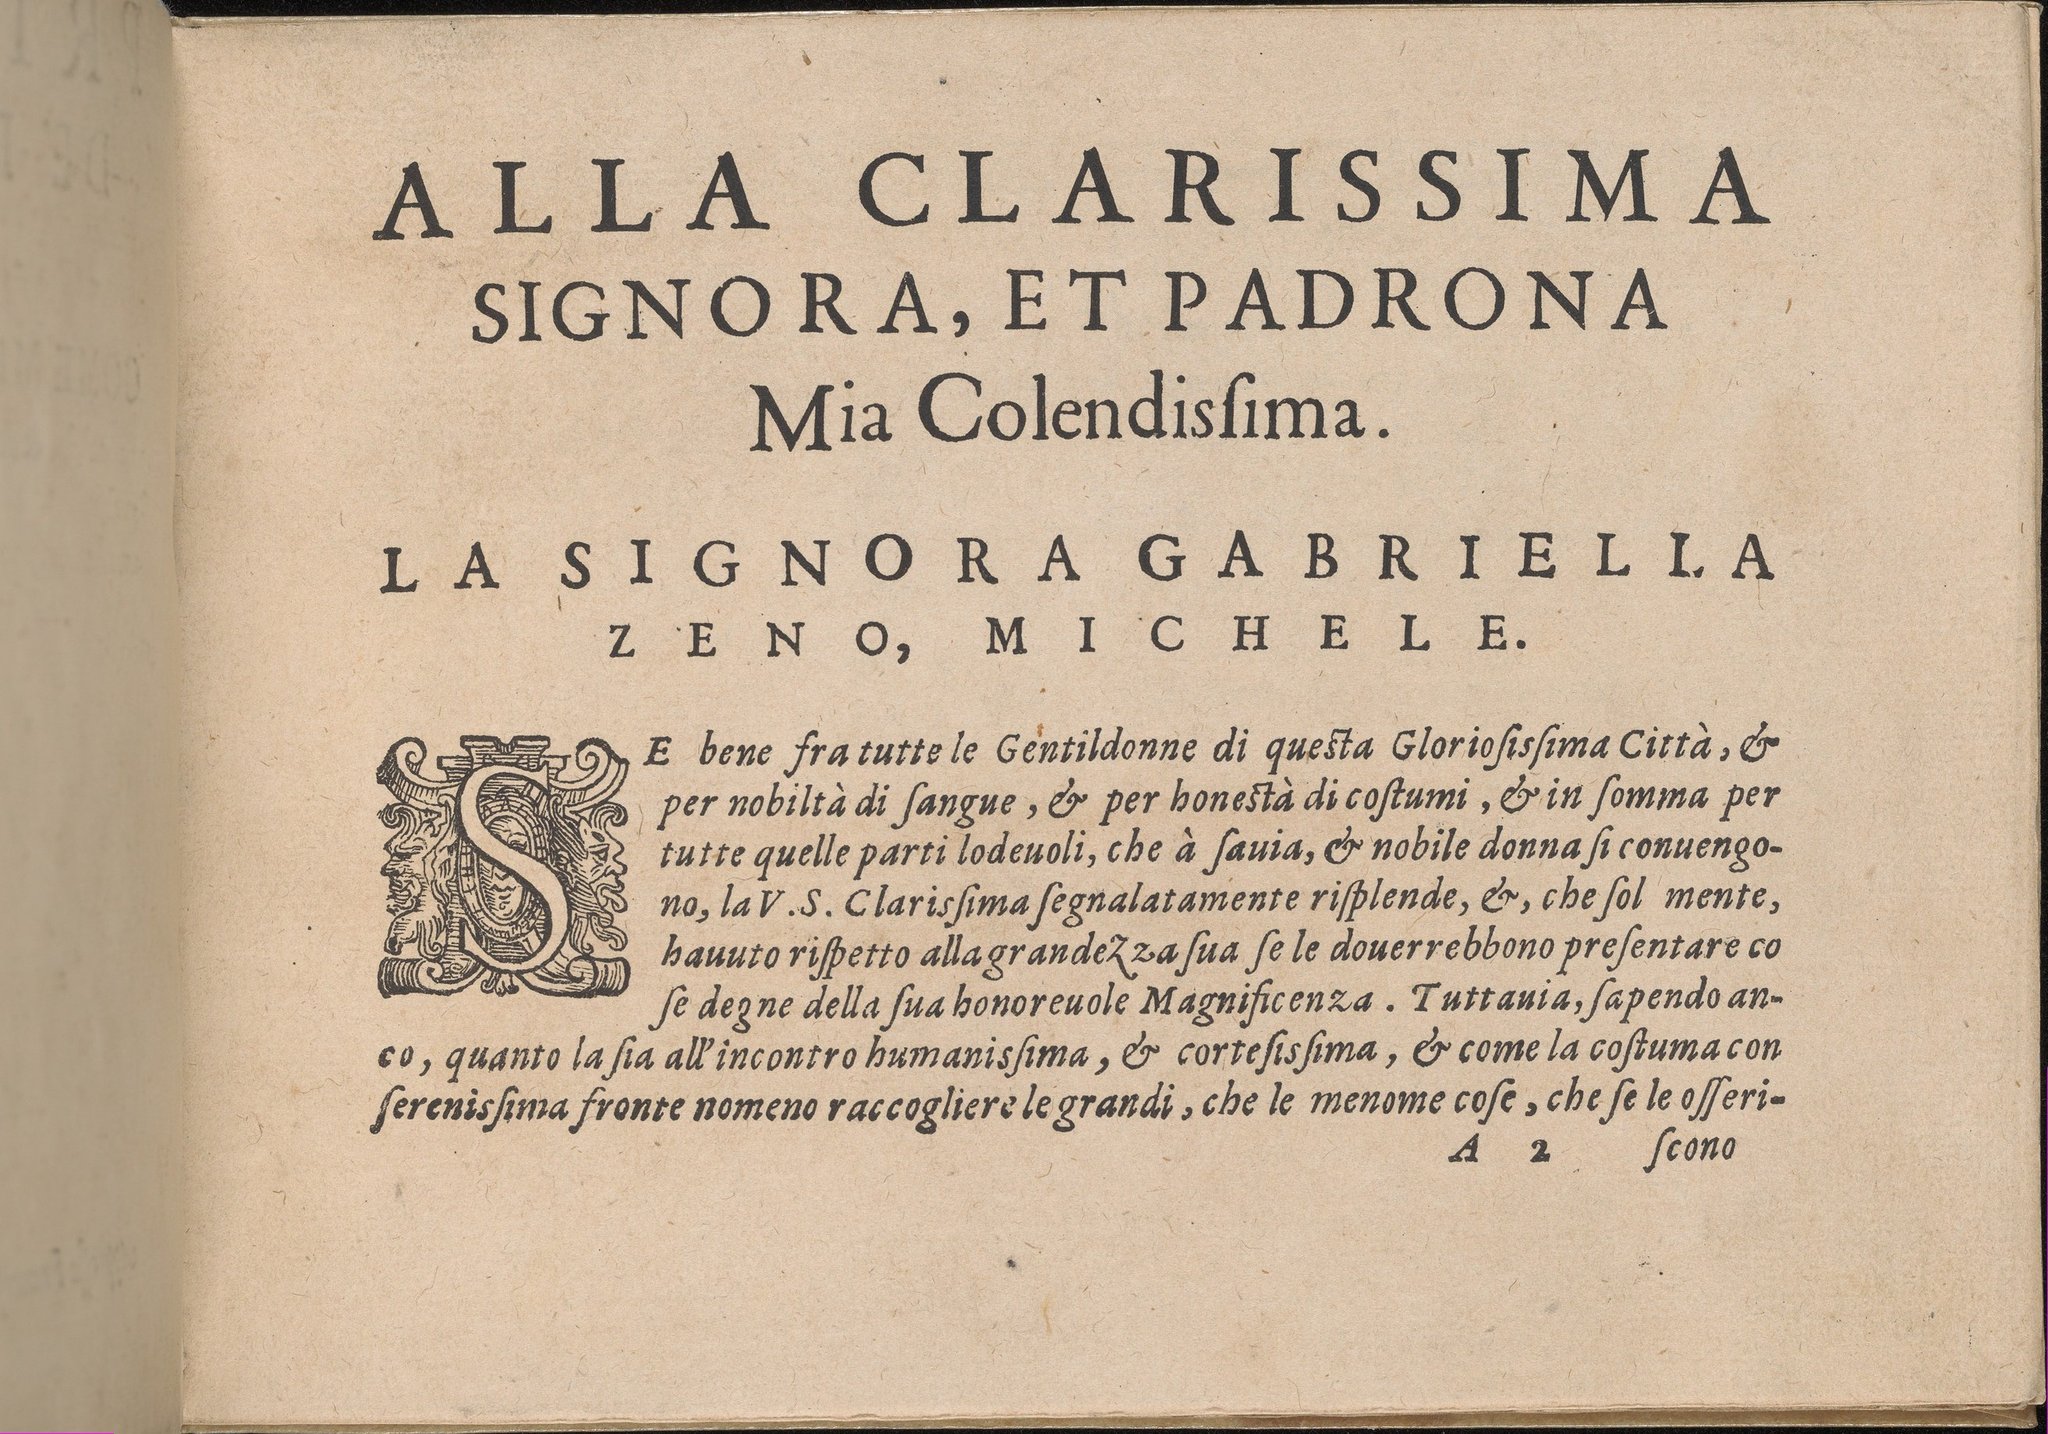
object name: book print ornament architecture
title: Prima Parte de' Fiori, e Disegni di varie sorti di Ricami Moderni, page 2 (recto)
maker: giovanni battista ciotti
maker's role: author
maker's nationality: italian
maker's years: 1555-1659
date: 1591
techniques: woodcut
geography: italy